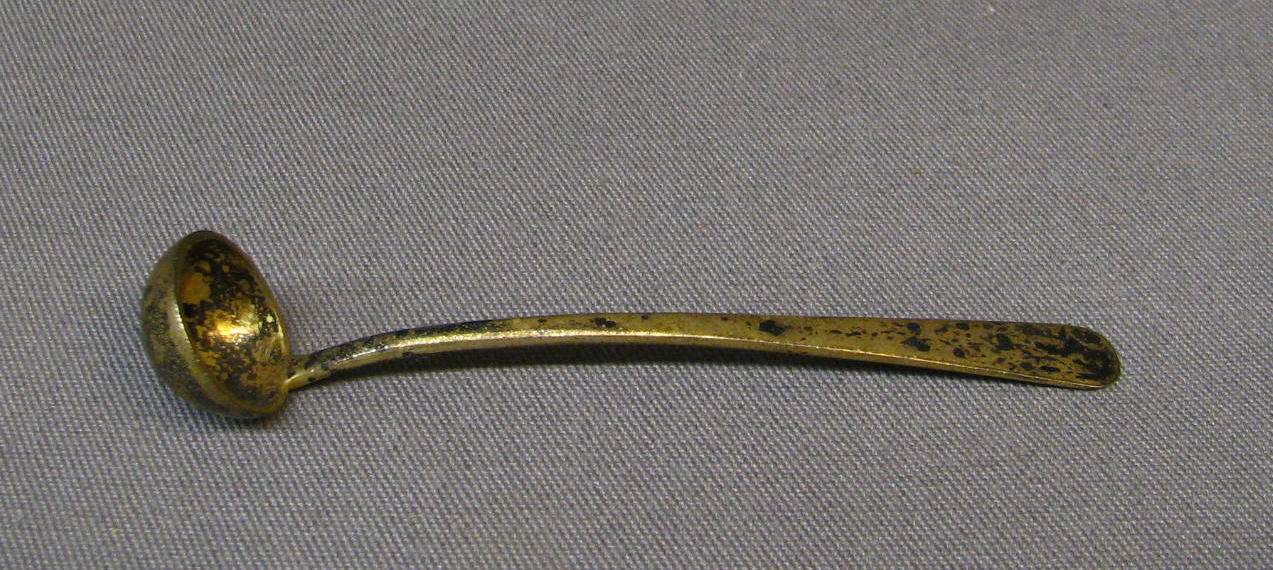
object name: caddy spoon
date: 1701-1800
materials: silver gilt